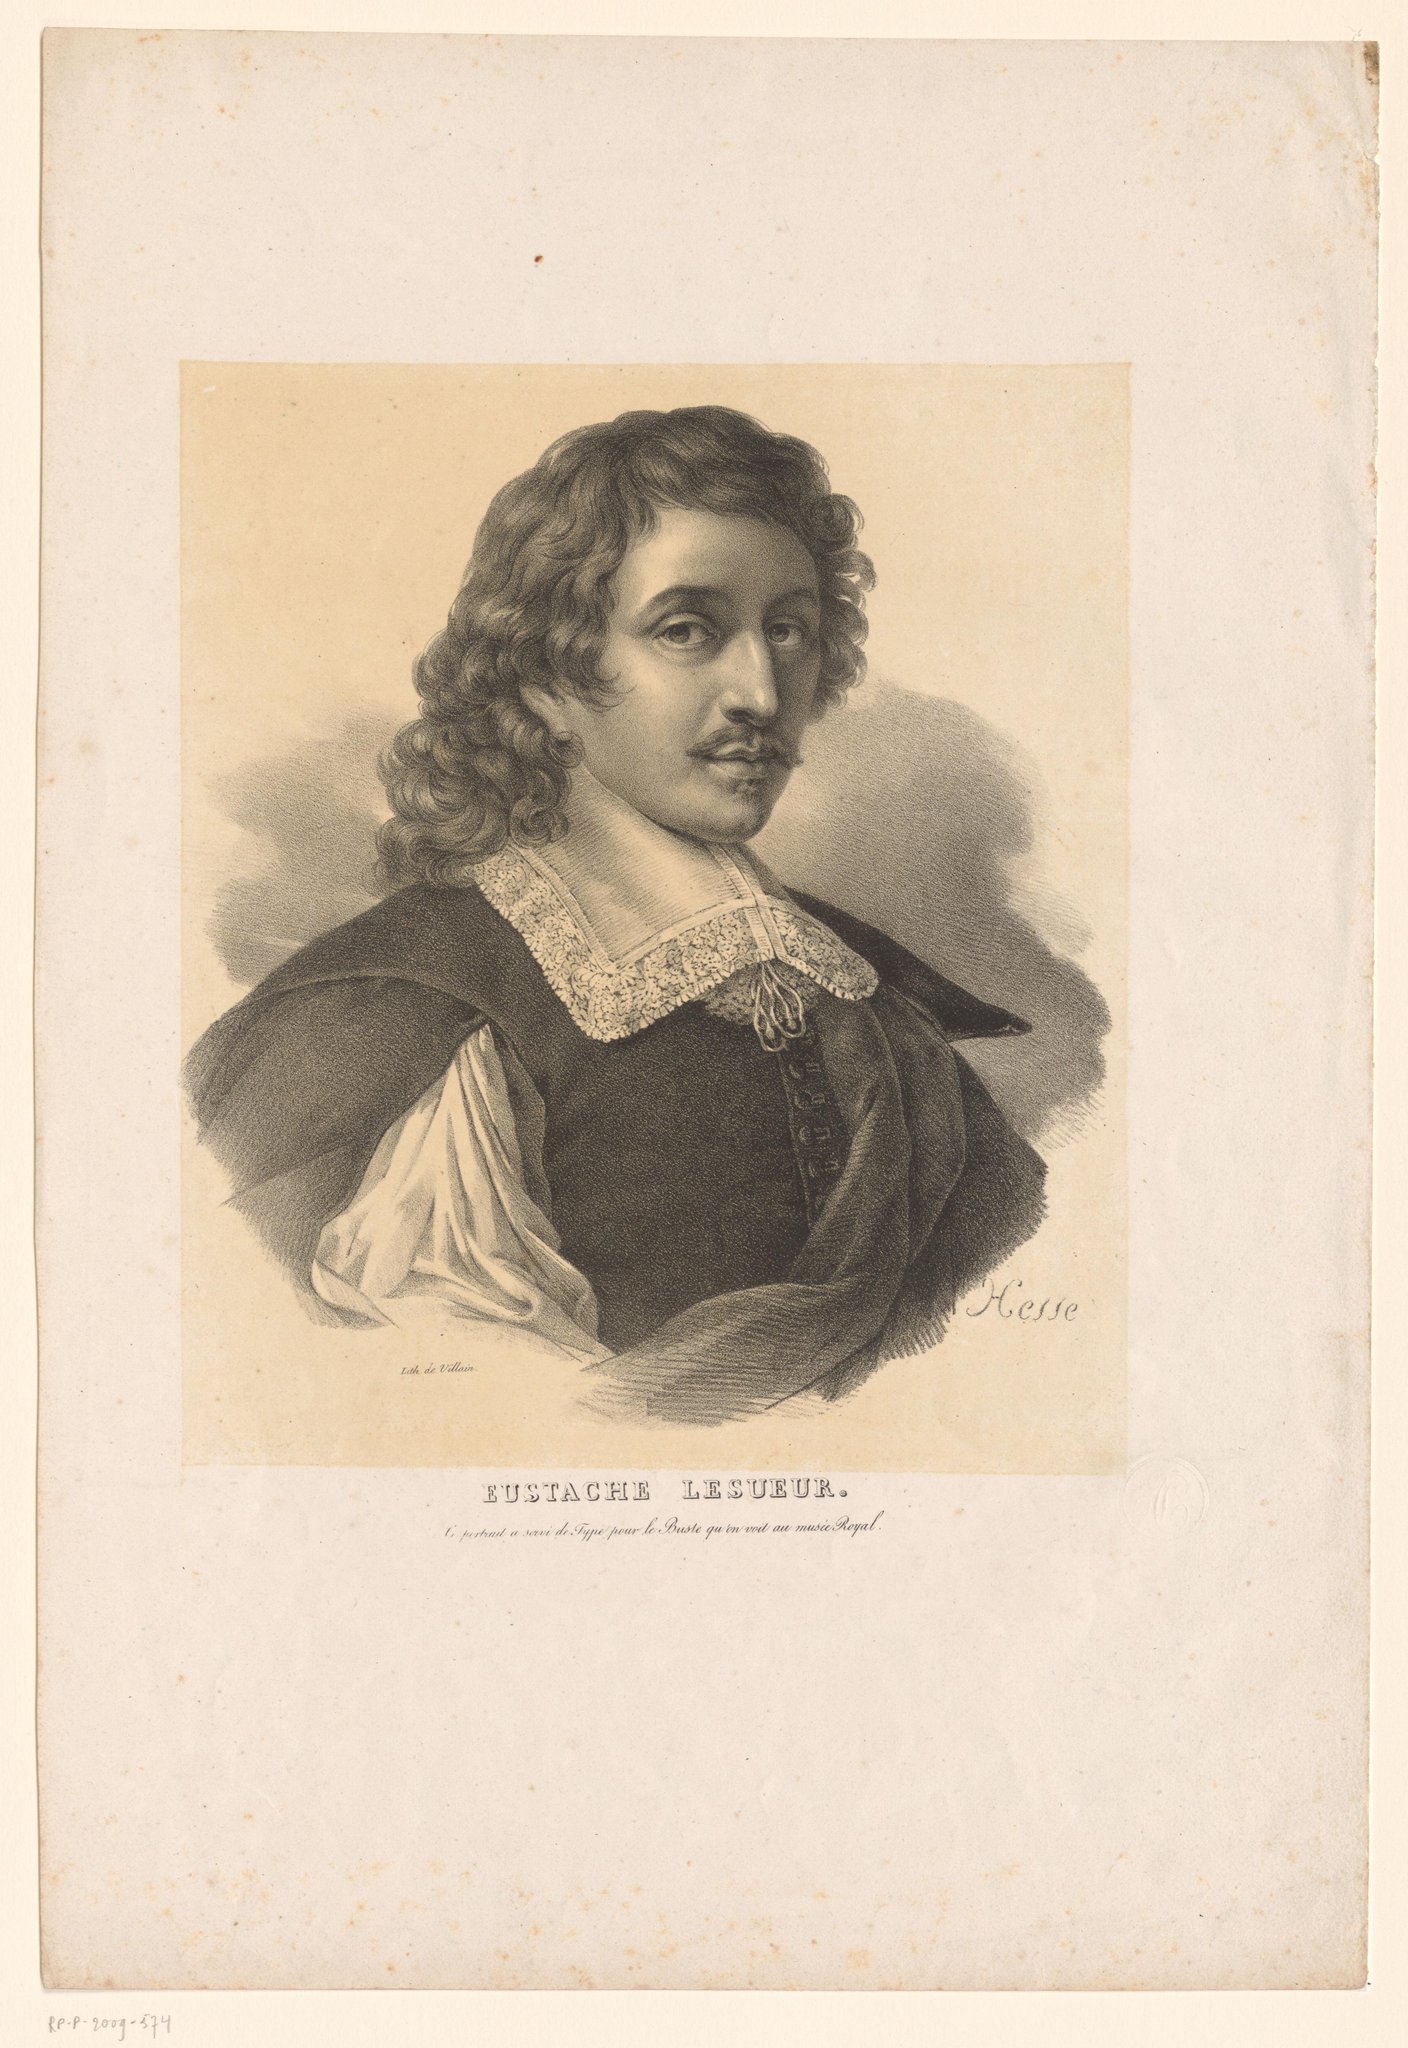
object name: print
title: Portret van Eustache Lesueur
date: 1818-1849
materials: paper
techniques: tone lithography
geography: paris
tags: paris, painter, eustache lesueur, historical persons, portrait, self-portrait of painter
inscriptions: check stamp: ‘JC’, collector's mark: Lugt 2228, stamp: ‘M/ v.S’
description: Prent waarschijnlijk uit: Chabert, M. Galerie des peintres ou collection de portraits des peintres les plus célèbres de toutes les écoles. Parijs: Jean-Claude Chabert, 1822-1834.